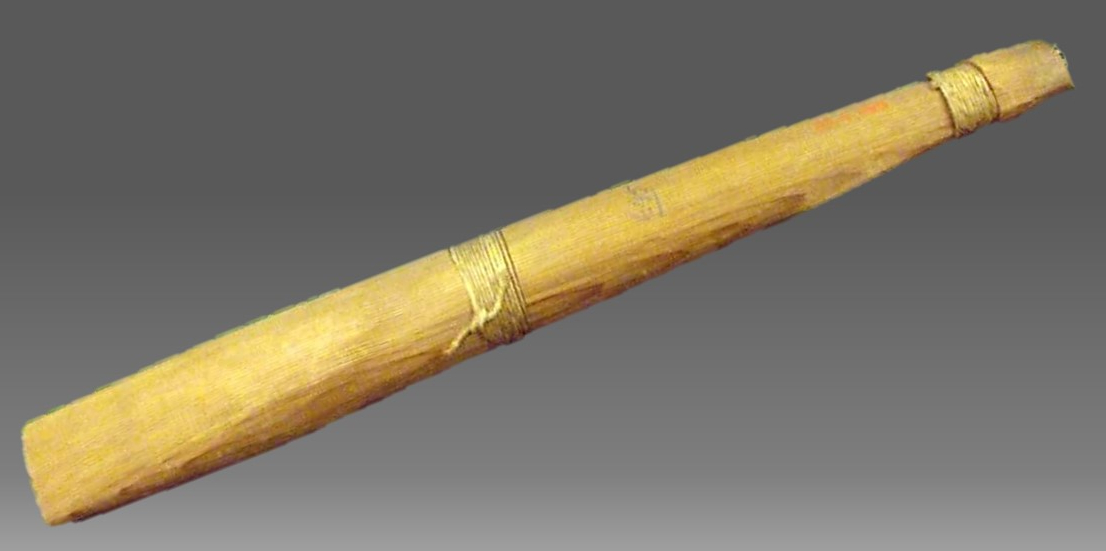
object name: k'oak'omolakula reminal retreating reed pipe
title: Reed Pipe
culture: native american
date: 1801-1900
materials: wood, cord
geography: canada